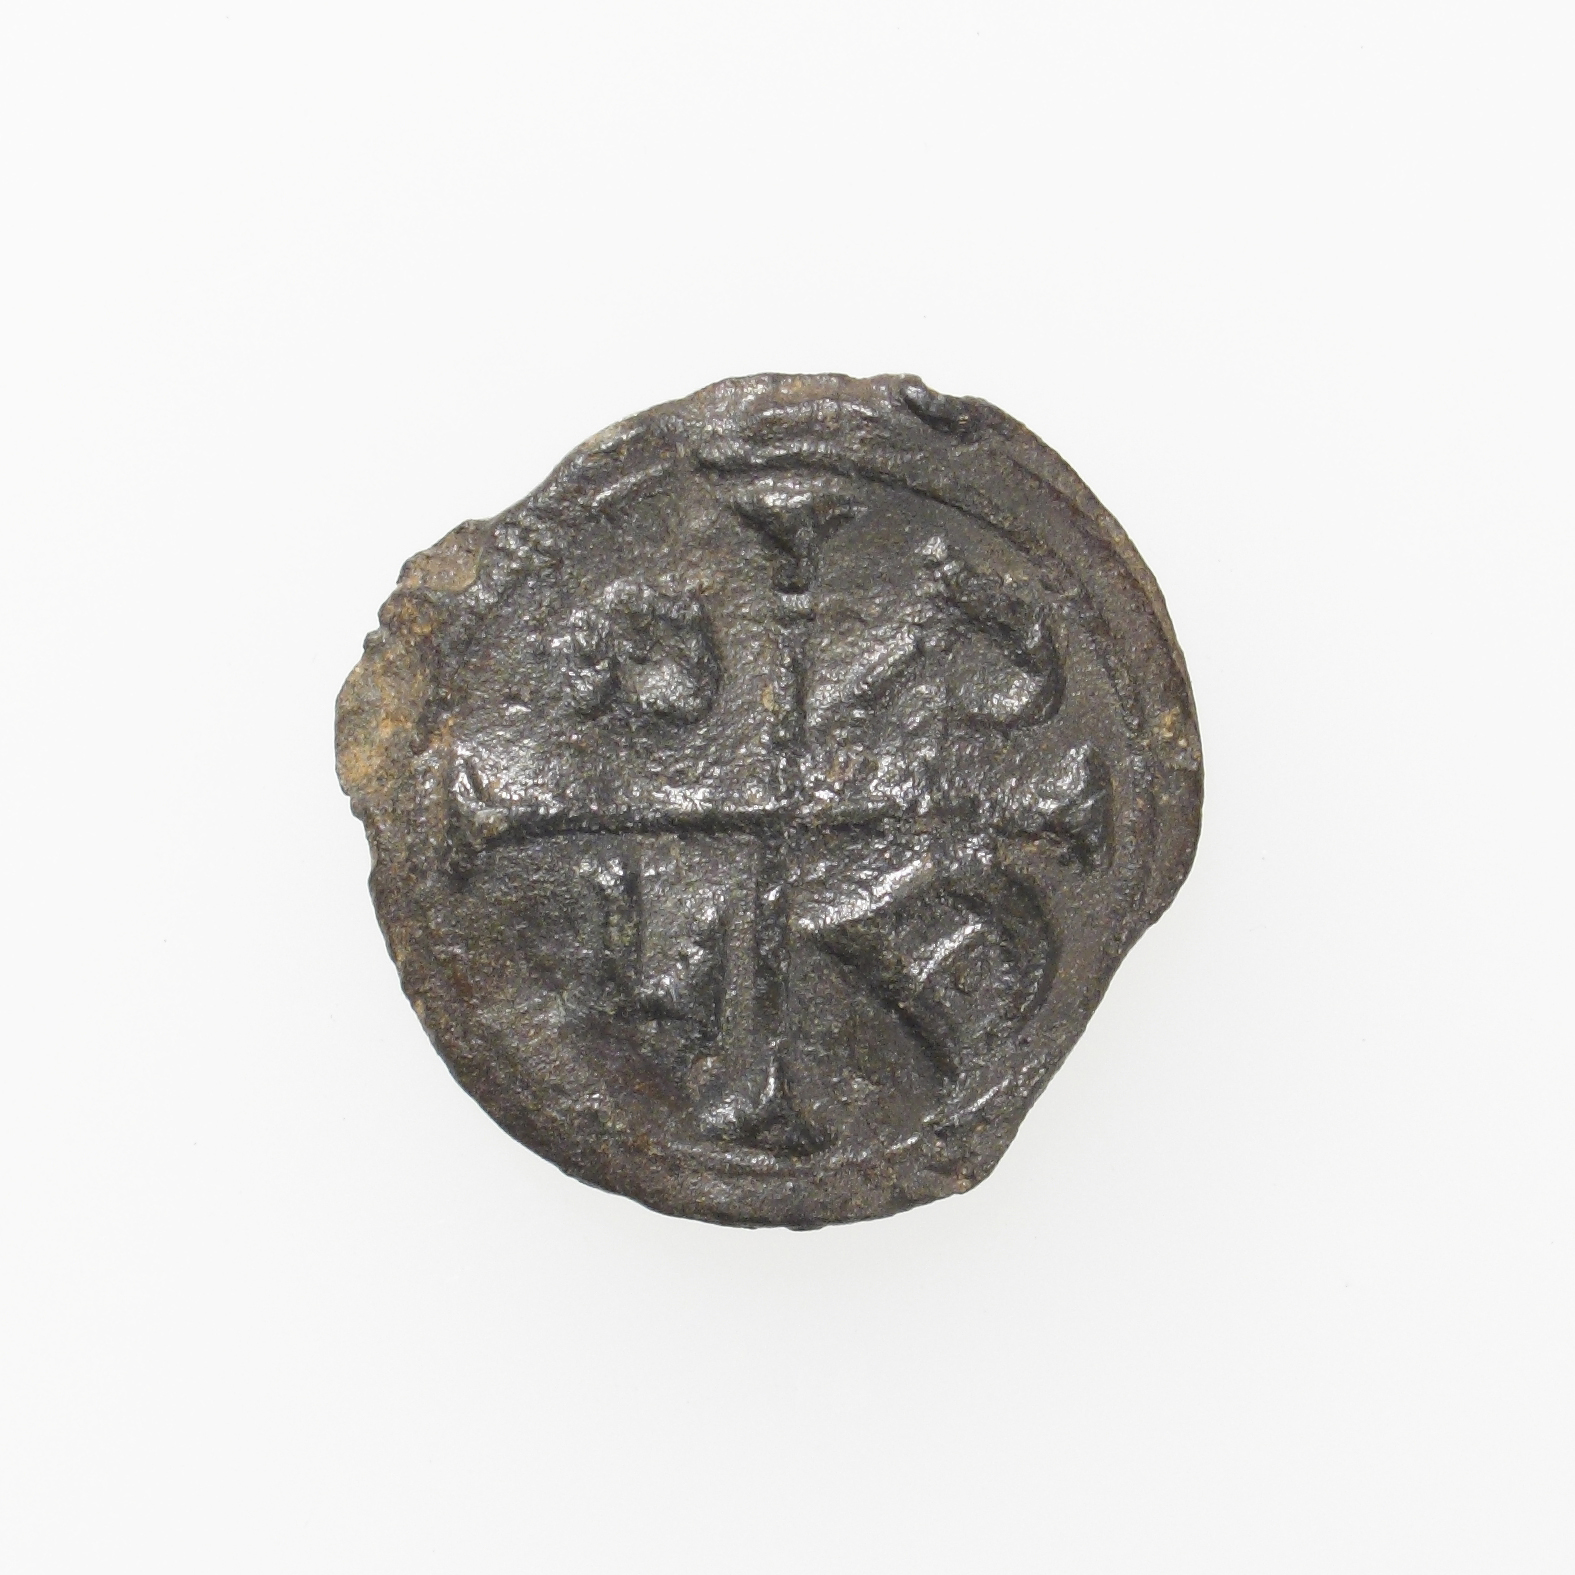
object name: pilgrim's badge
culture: french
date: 1301-1600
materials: lead